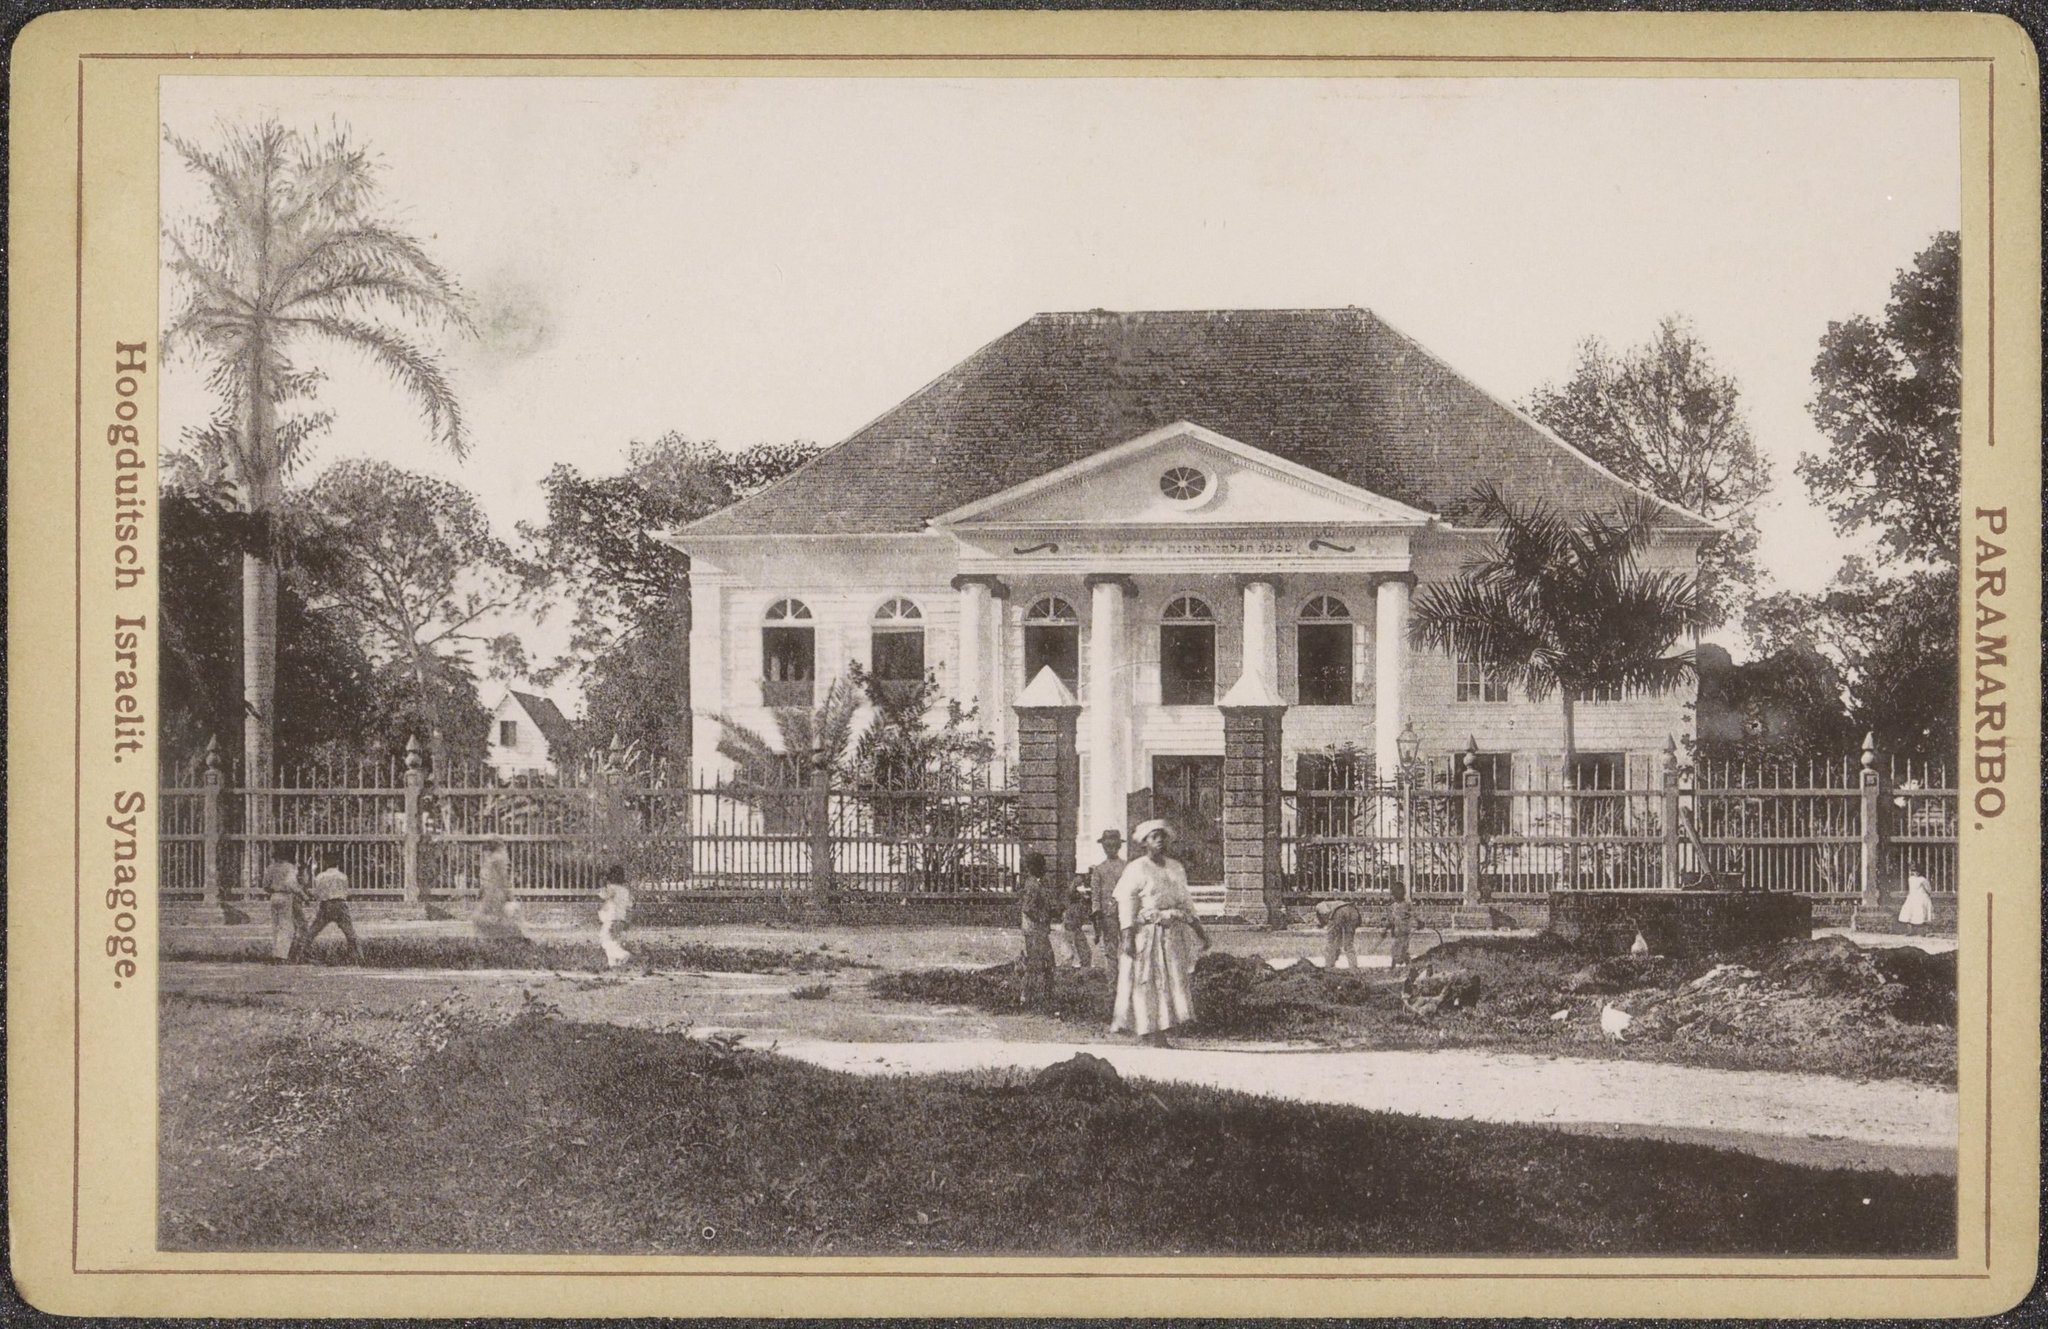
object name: cabinet photograph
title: Paramaribo. Hoogduitsch Israëlit. Synagoge.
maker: eugen klein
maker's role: fotograaf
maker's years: 1869-1927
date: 1900-1927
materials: cardboard, paper, ink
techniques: photograph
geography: paramaribo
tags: the synagogue (as building and place of worship ~ jewish religion), travelling; tourism, prospect of city, town panorama, silhouette of city, suriname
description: Onderdeel van Fotoalbum met bezienswaardigheden in Paramaribo.